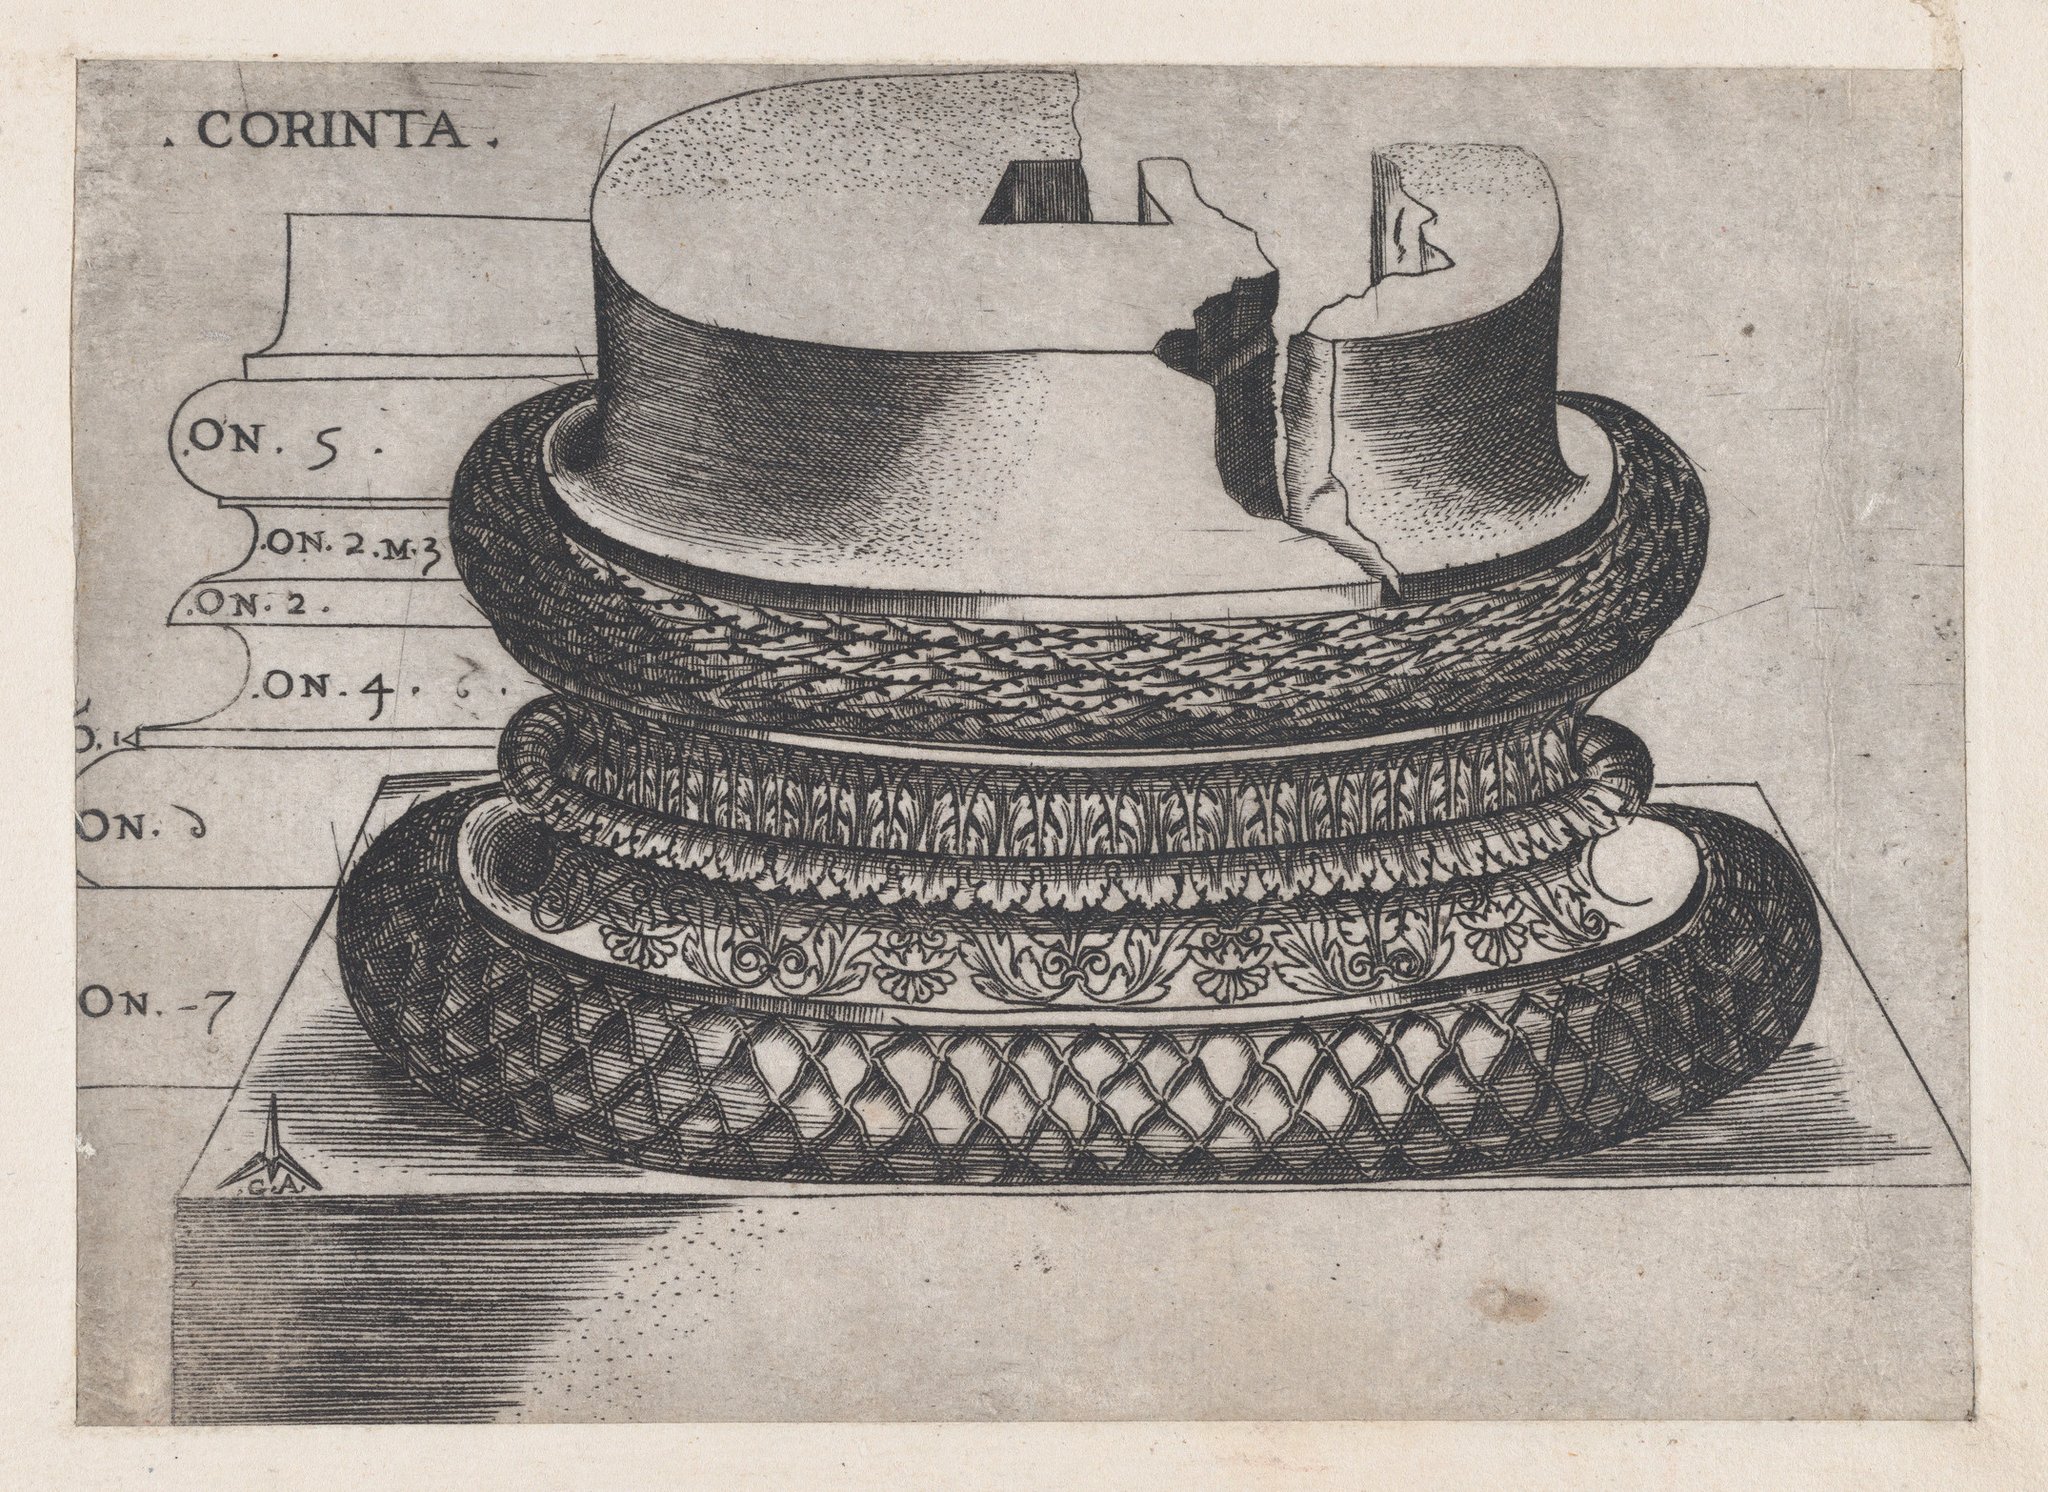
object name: print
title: Corinthian base from the Lateran Baptistery, Rome, from "Speculum Romanae Magnificentiae"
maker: monogrammist g.a. with the caltrop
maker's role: artist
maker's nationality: italian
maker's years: 1535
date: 1537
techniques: engraving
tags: architecture